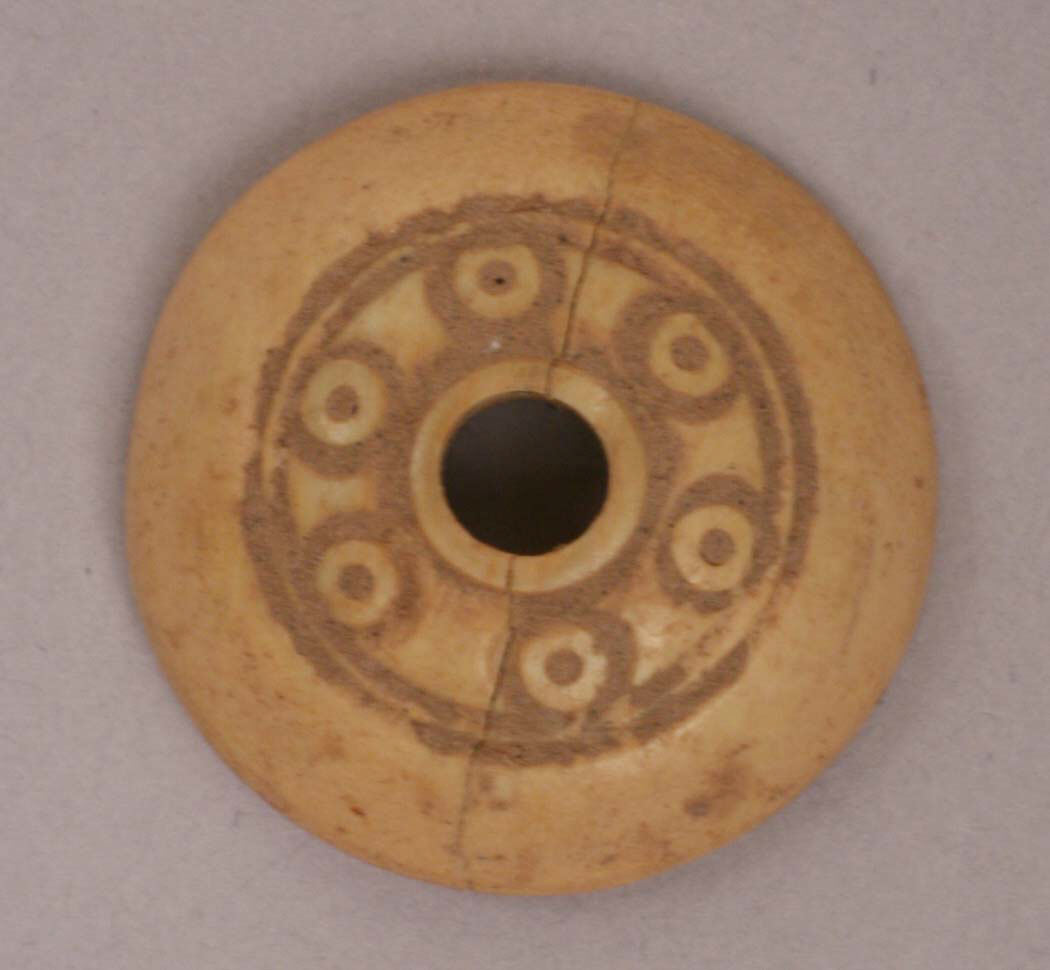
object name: button or bead or spindle whorl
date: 801-1000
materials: bone, paint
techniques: incising, inlay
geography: iran